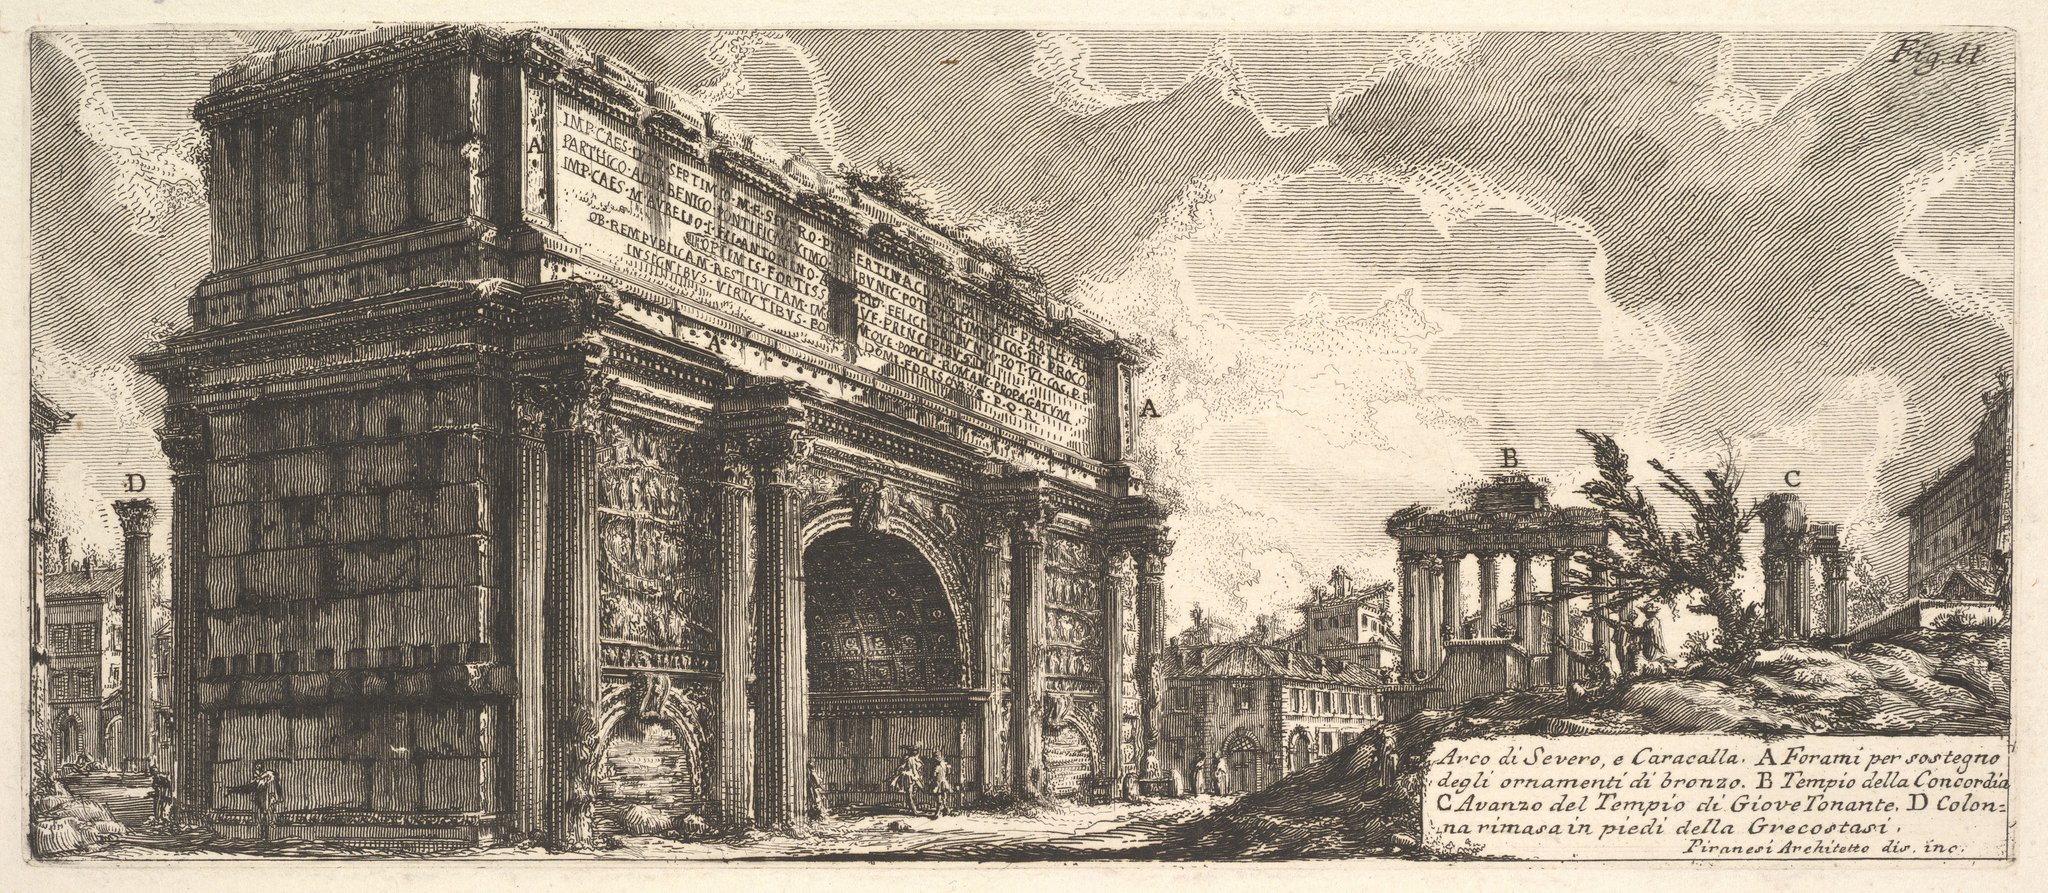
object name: print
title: The Arch of Septimius Severus (Arco di Severo, e Caracalla)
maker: giovanni battista piranesi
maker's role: artist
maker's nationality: italian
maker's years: 1720-1778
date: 1756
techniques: etching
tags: architecture,arches,ruins